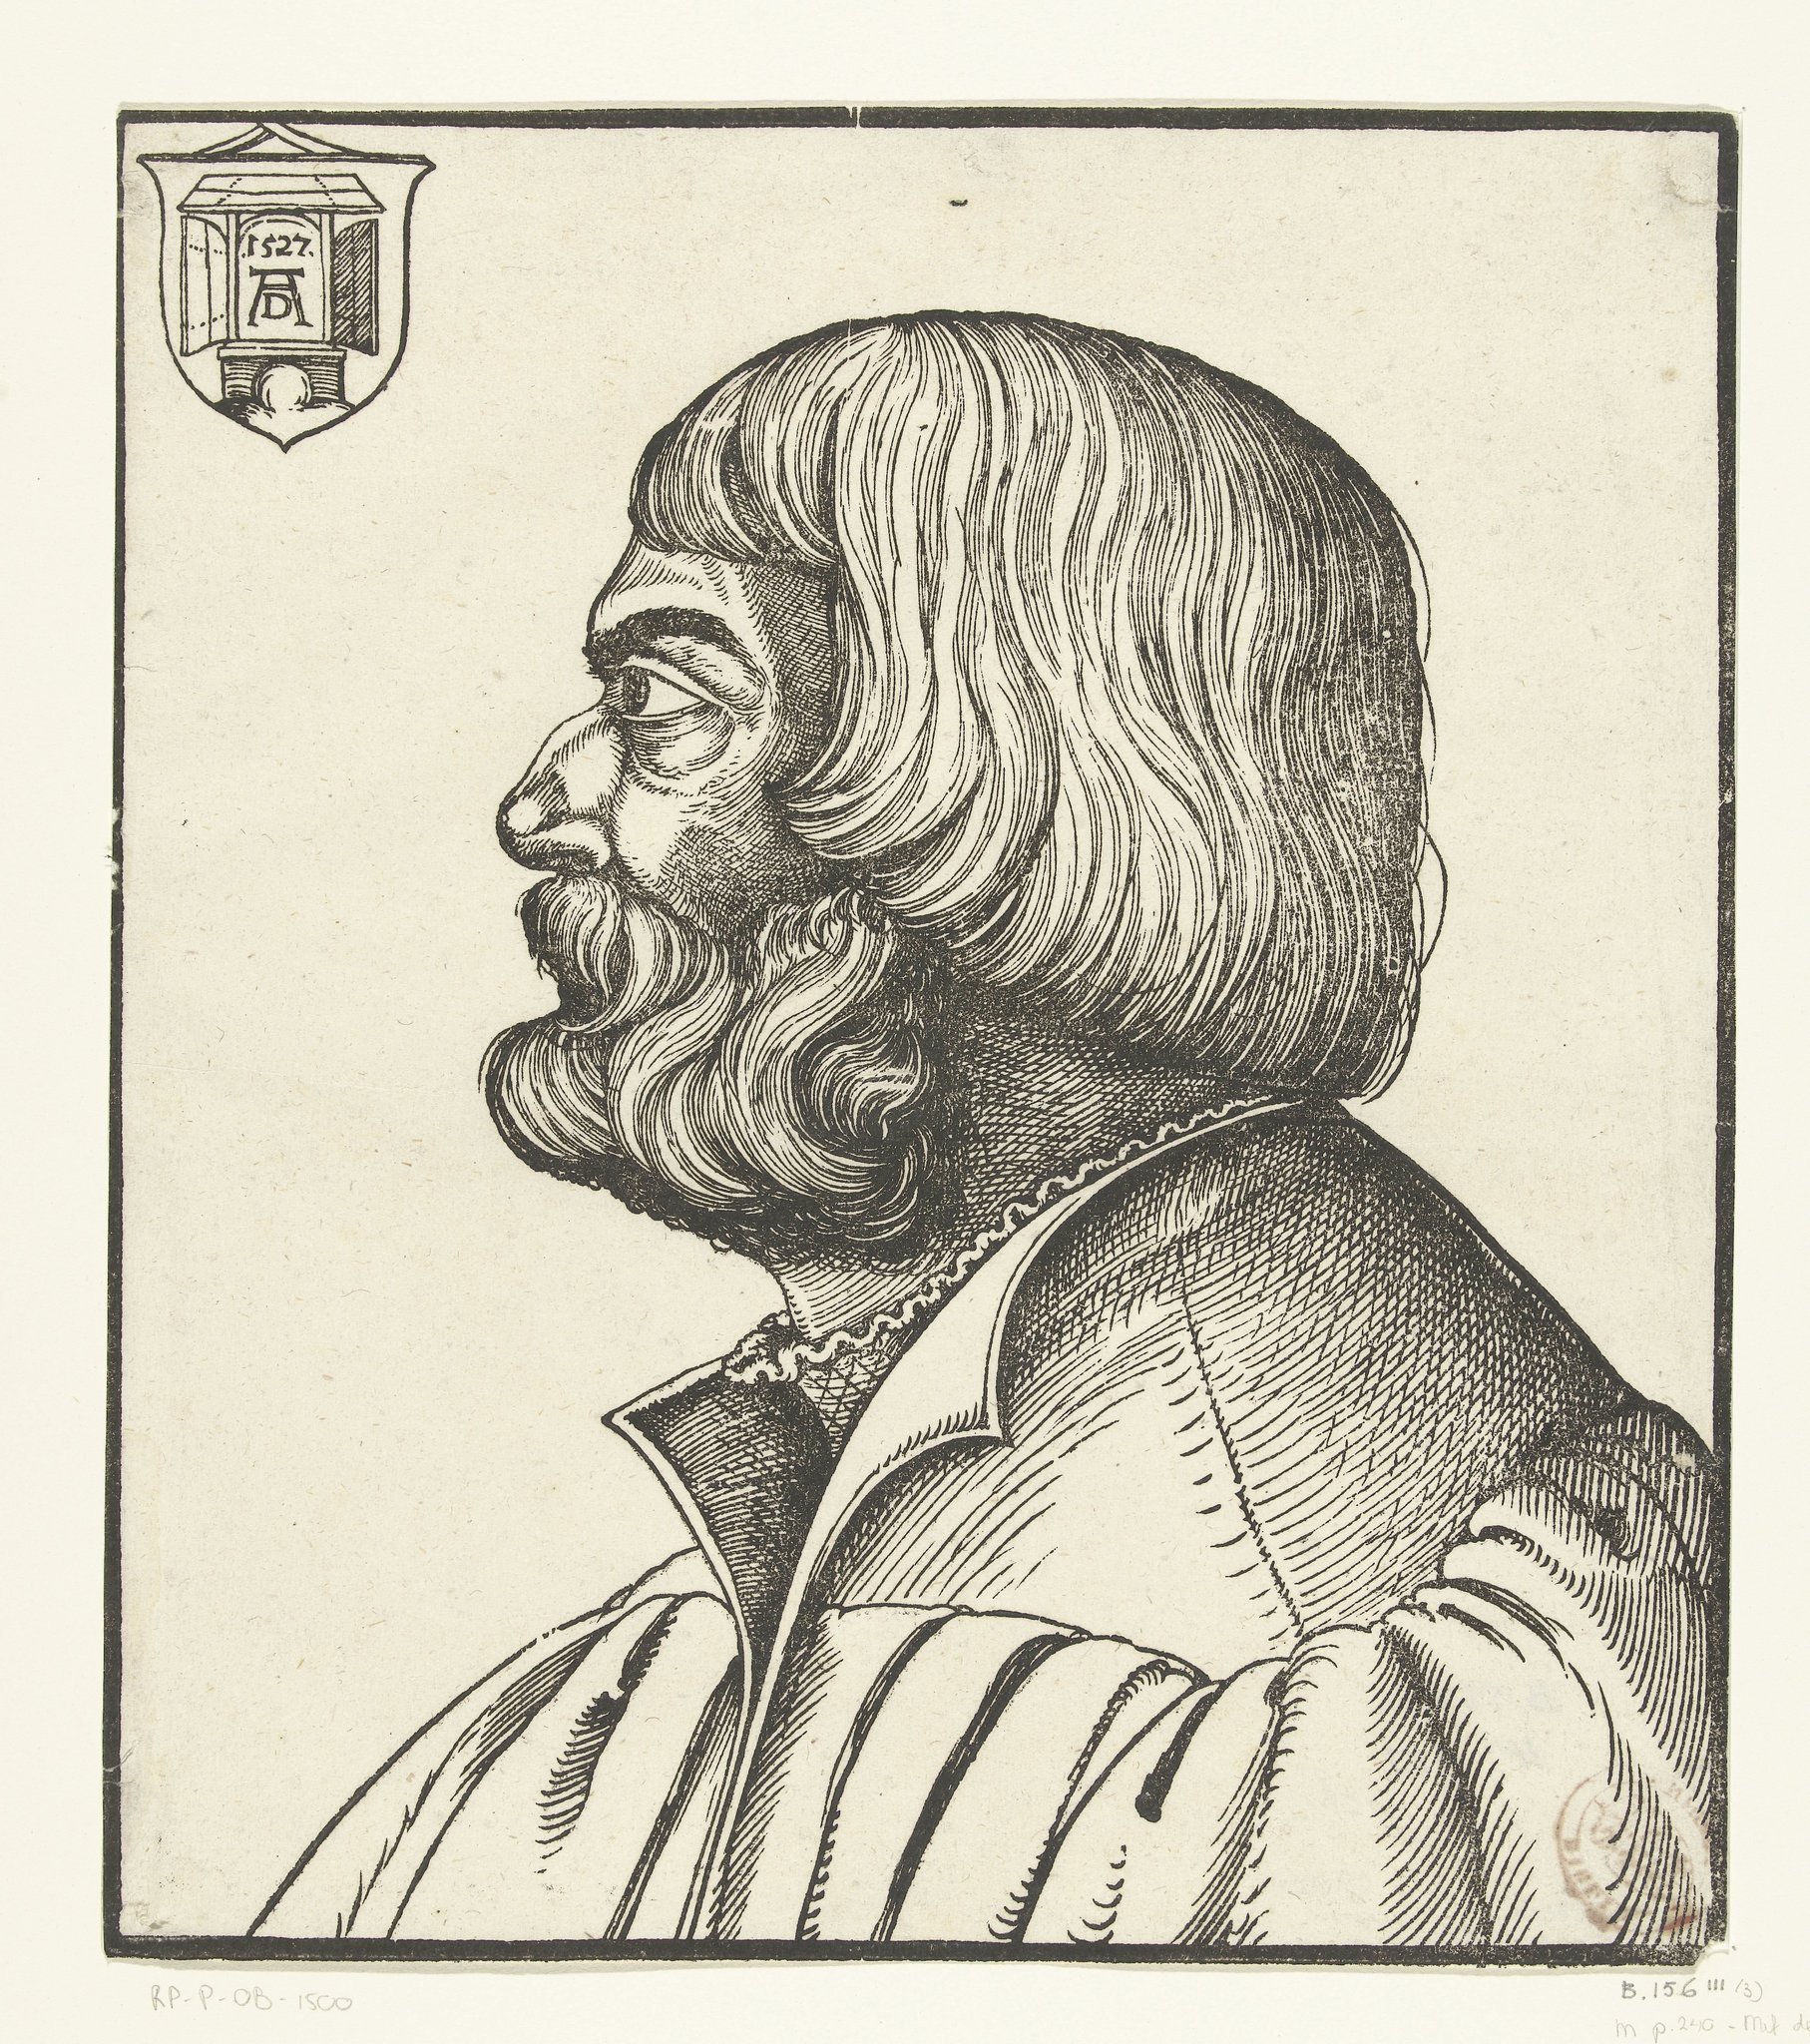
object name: print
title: Portret van Albrecht Dürer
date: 1527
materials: paper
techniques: woodcut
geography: nuremberg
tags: painter, print maker, draughtsman, albrecht dürer, historical persons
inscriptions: collector's mark: Lugt 240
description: Portret van Albrecht Dürer, naar links. Klein wapenschild linksboven, met monogram en datering.